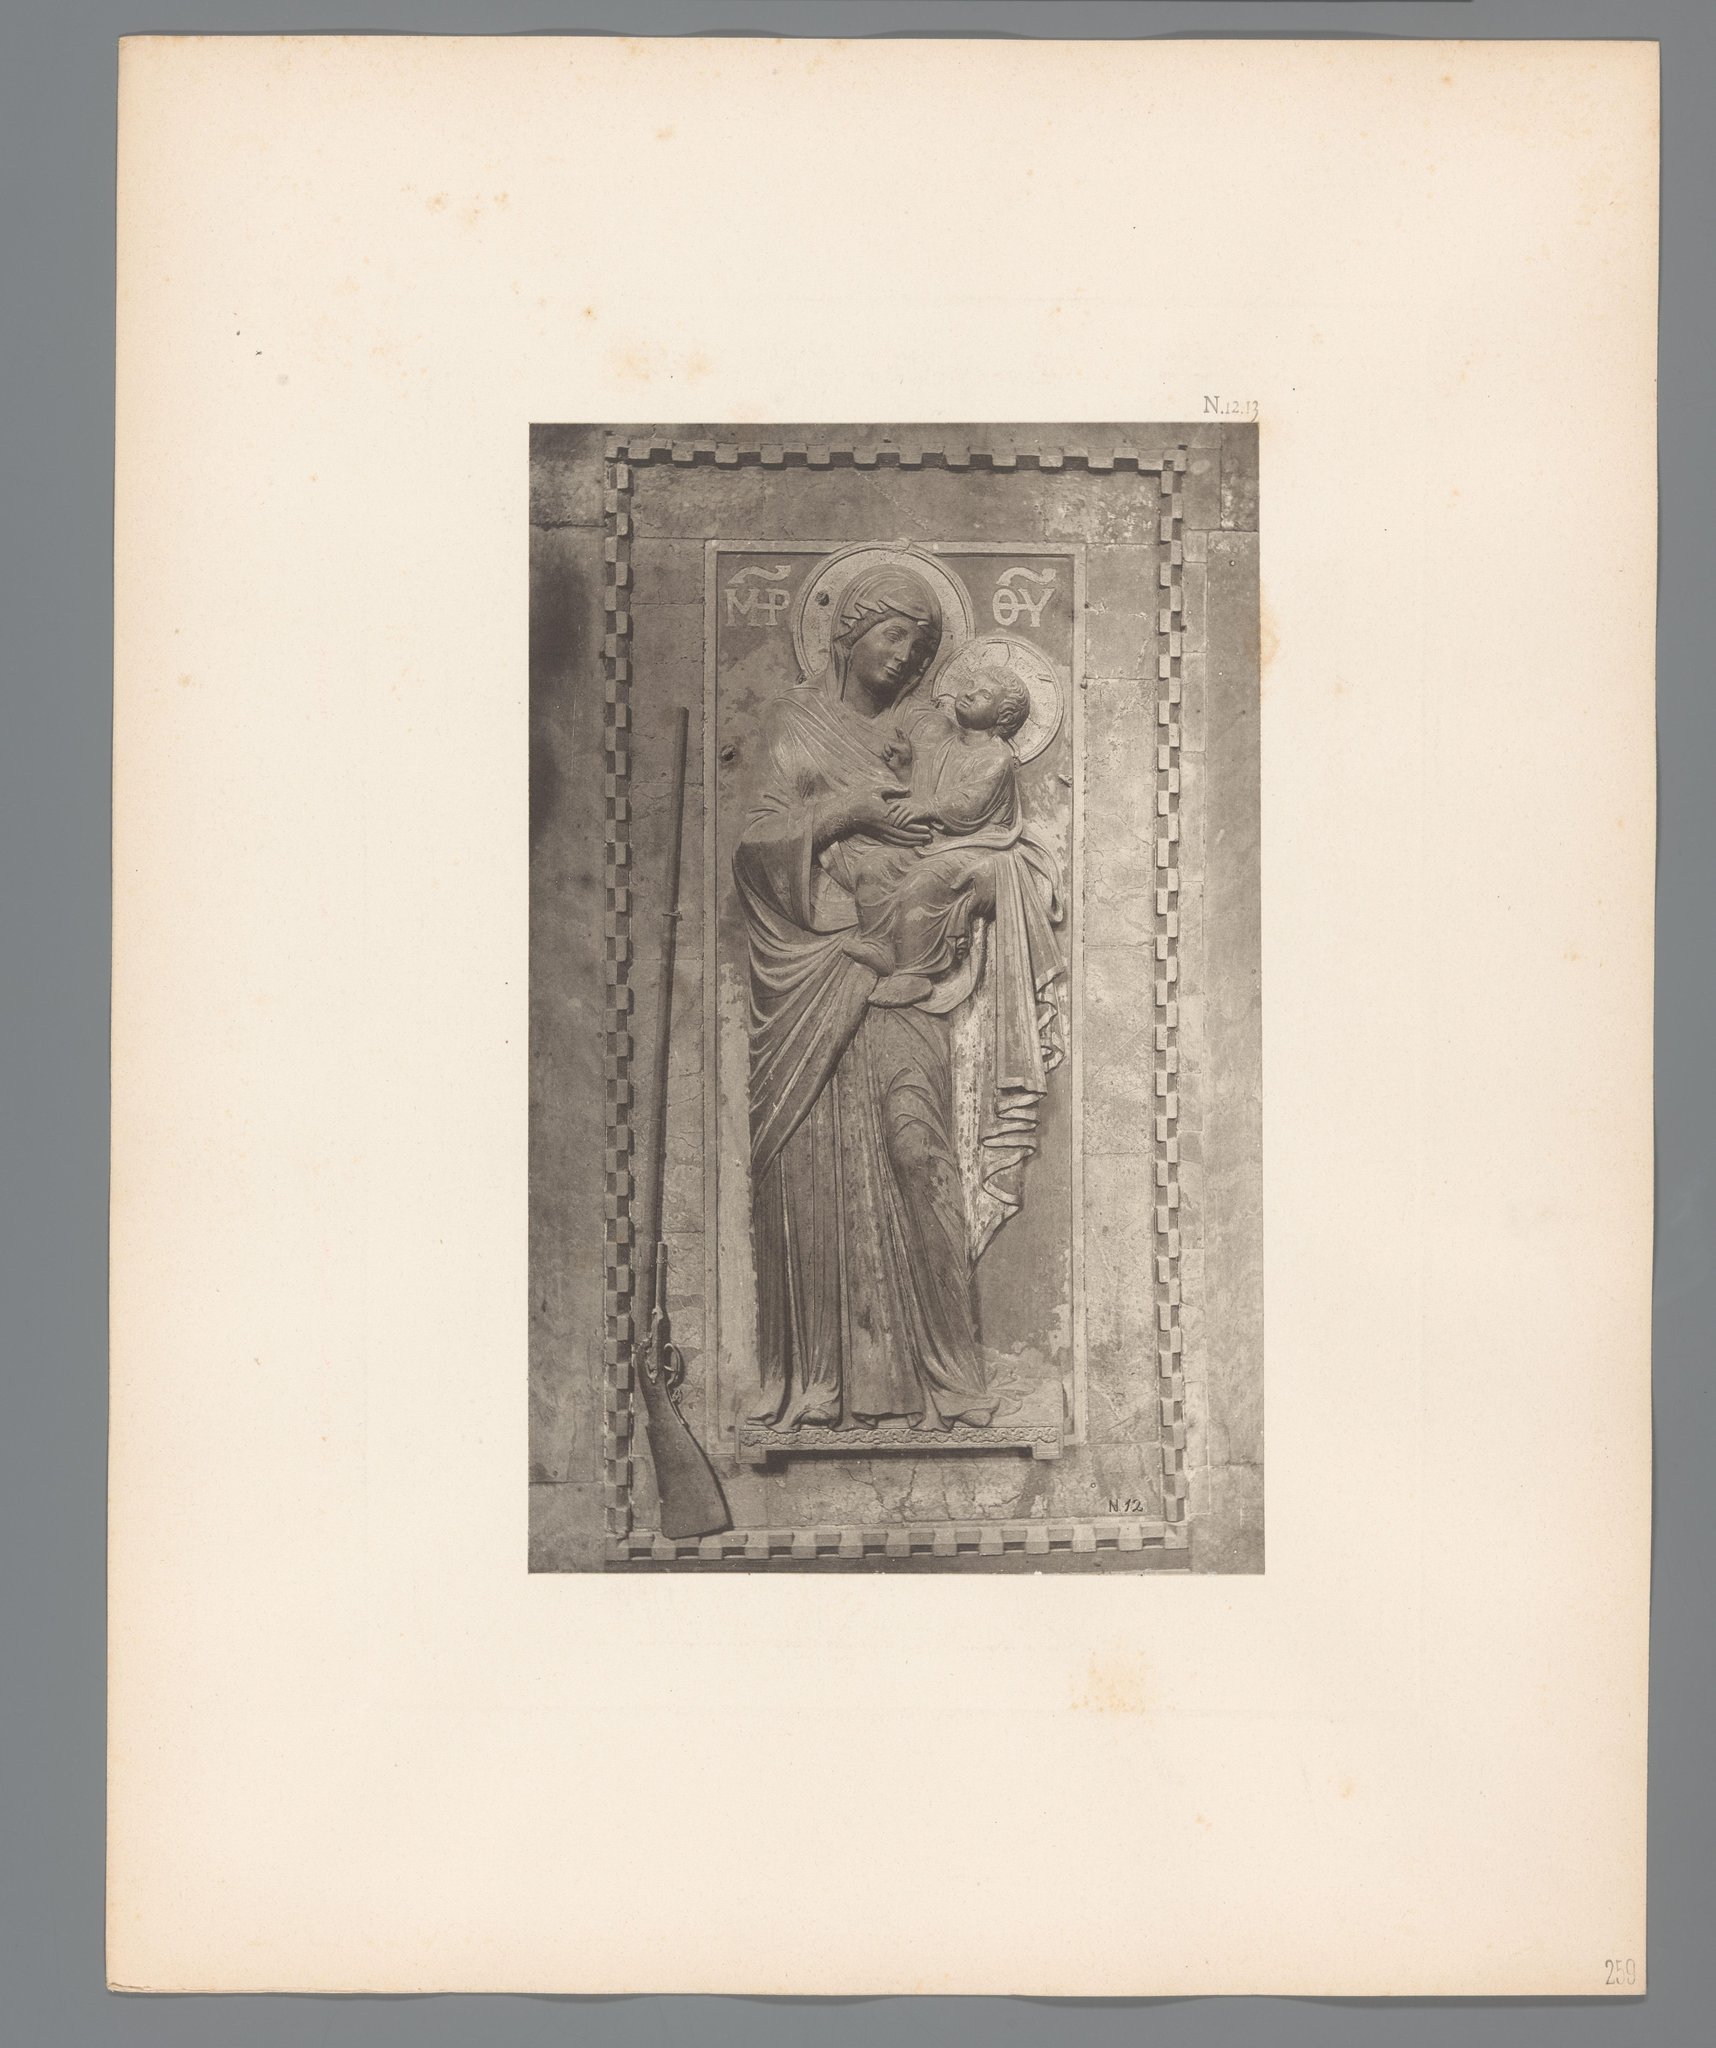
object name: photomechanical print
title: Reliëf van Maria en Christus in de San Marco in Venetië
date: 1880-1885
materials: paper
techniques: photograph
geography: st. mark's basilica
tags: mary standing (or half-length), the christ-child sitting on her arm (christ-child to mary's left), piece of sculpture, reproduction of a piece of sculpture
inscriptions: number: ‘N.12.13’, number: ‘259’, number: ‘N.12’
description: Deze prent maakt deel uit van een omslag met 58 prenten op 50 bladen.